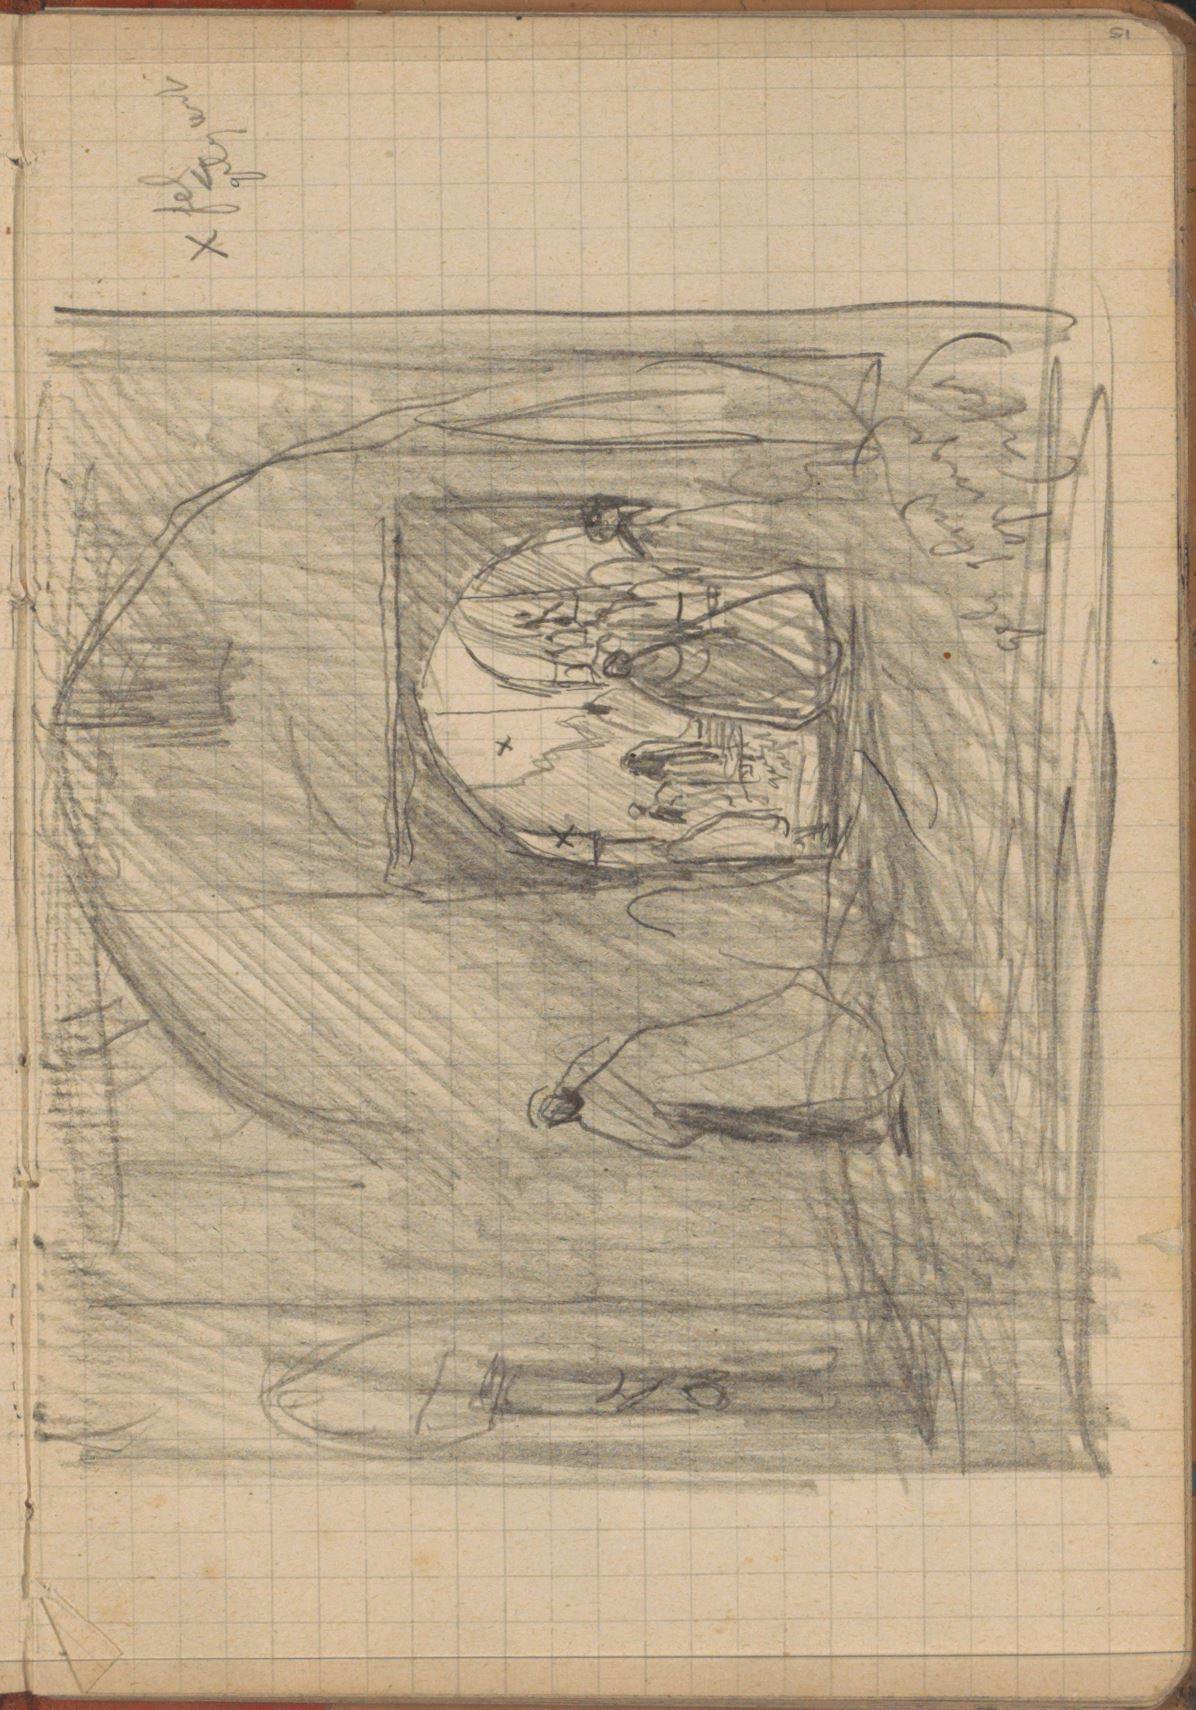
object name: sketchbook leaf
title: Figuren in een straat met poorten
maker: marius bauer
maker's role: draughtsman, print maker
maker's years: 1867-1932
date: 1909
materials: pencil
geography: tunis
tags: arch, archivolt ~ architecture, street (+ city(-scape) with figures, staffage)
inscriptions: kleurnotitie, handgeschreven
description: Pagina 51 uit een schetsboek met 67 bladen.